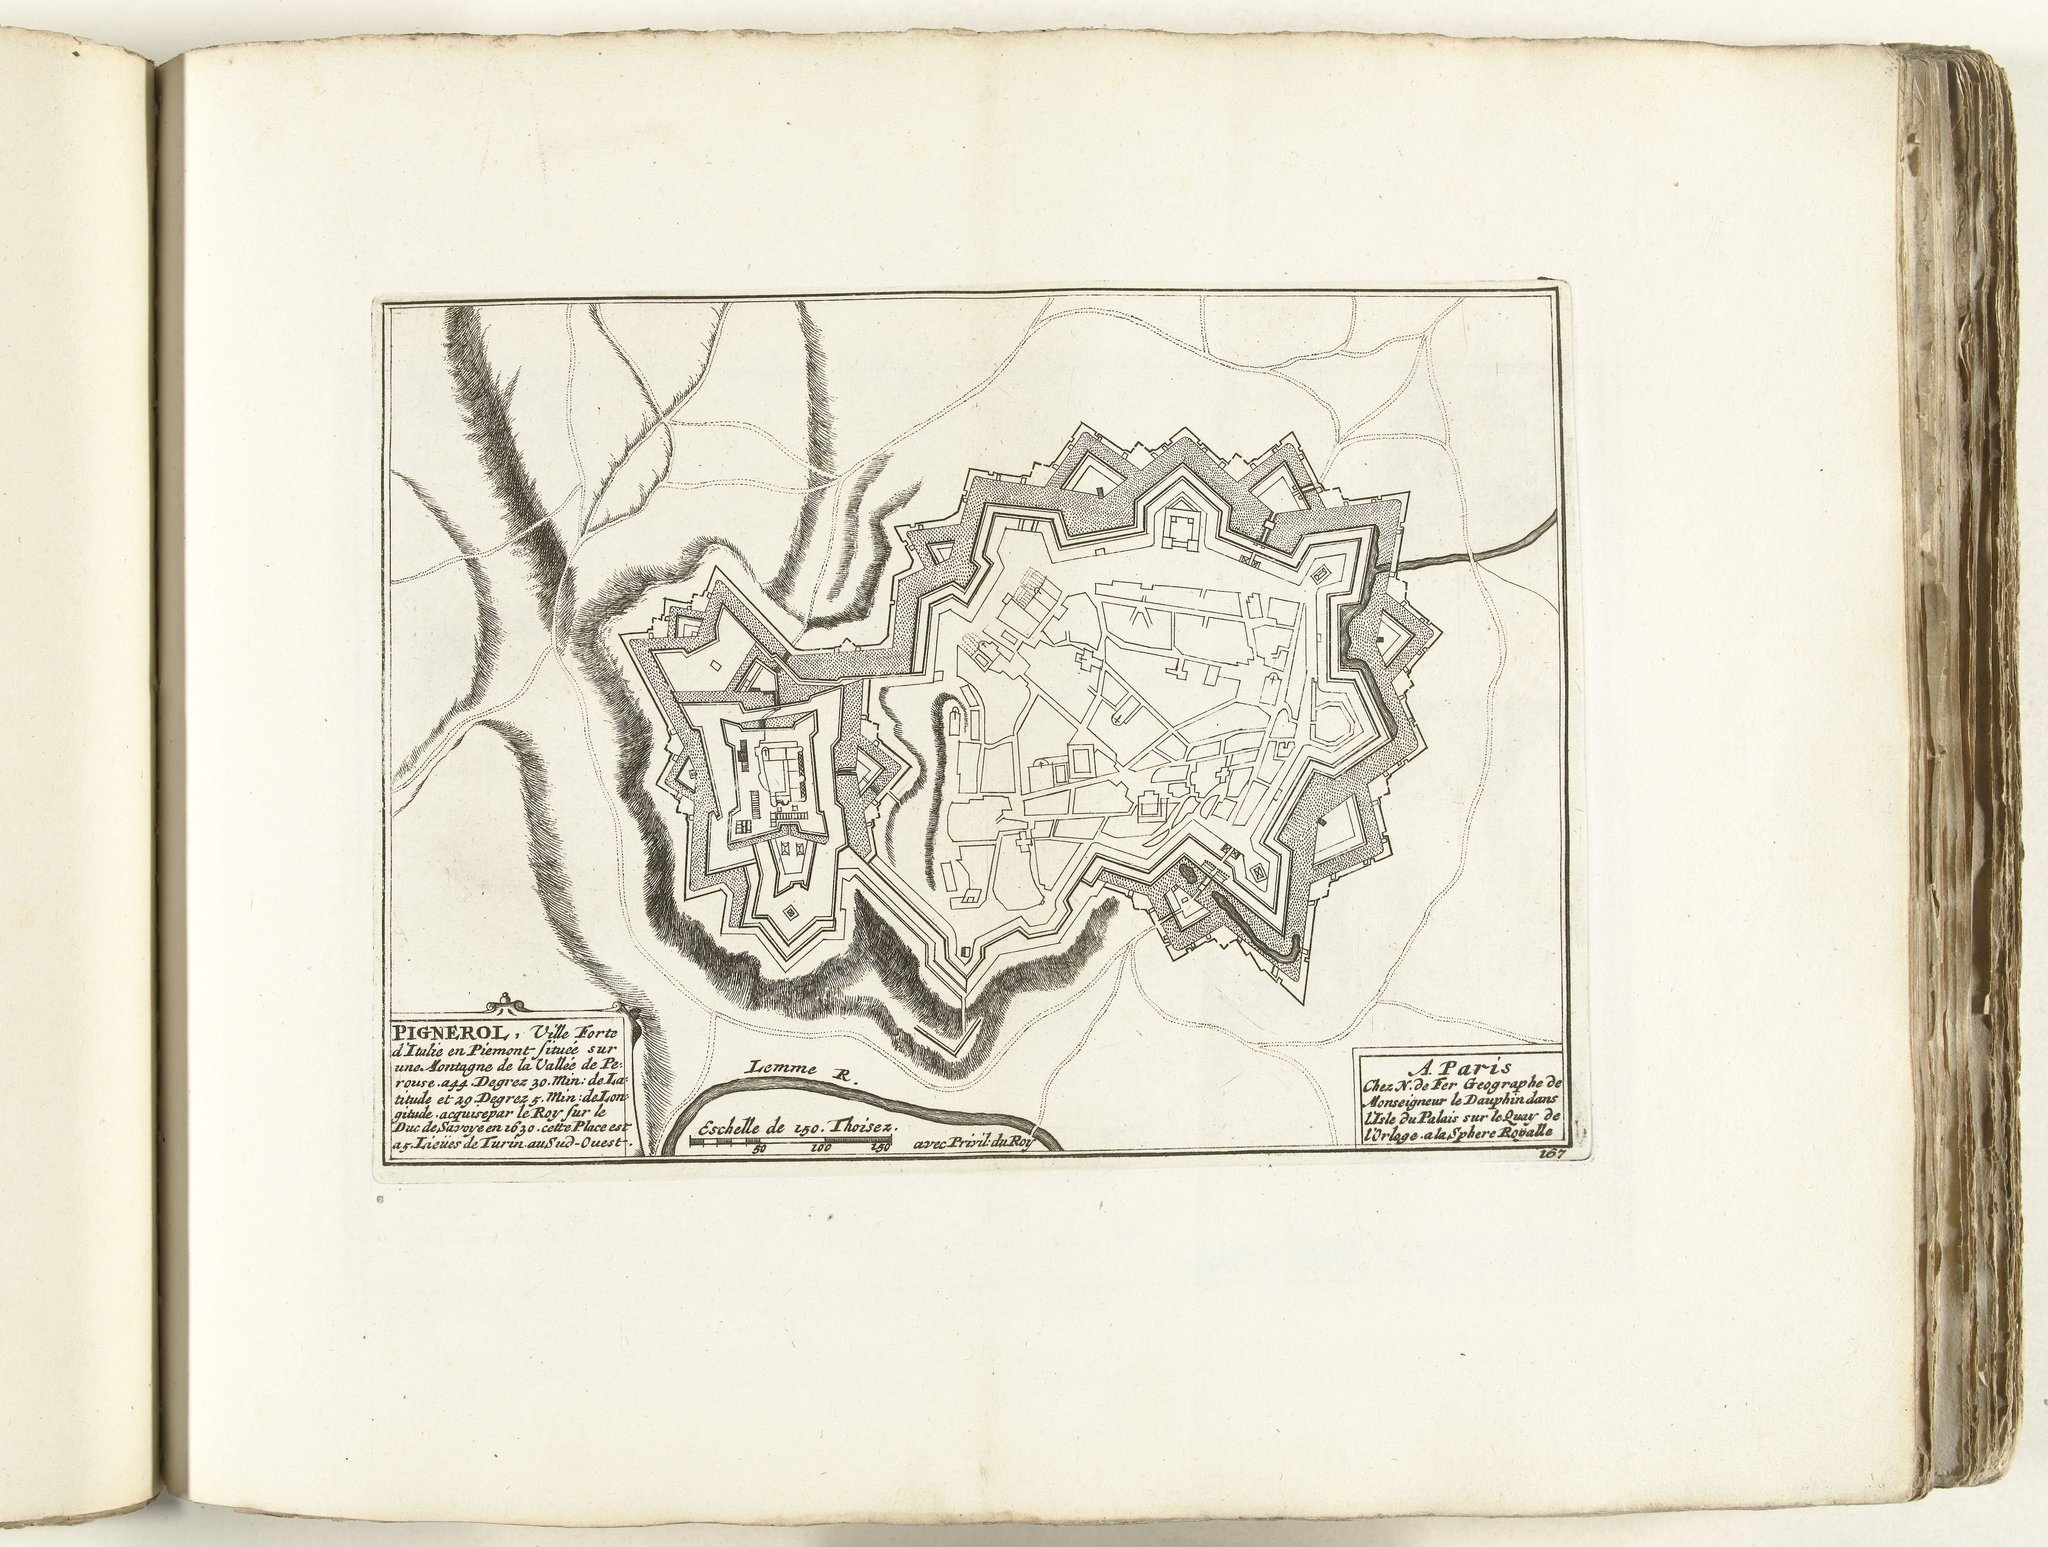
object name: print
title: Pignerol, Ville Forte d'Italie en Piemont (...)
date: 1702-1703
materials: paper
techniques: etching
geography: paris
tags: fortress, maps of cities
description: Plattegrond van de versterkingen om de Italiaanse stad Pinerolo (Pignerol). Plaat nr. 167 in het prentwerk bestaande in totaal uit 276 genummerde platen van vermaarde sterke steden en vestingen in het kader van de Spaanse Successieoorlog. Voor het merendeel zijn deze platen gekopieerd naar de anonieme Franse platen: in Les forces de l'Europe en in: Le theatre de la guerre, dans les Pays-Bas, beide oorspronkelijk uitgegeven door Nicolas de Fer te Parijs (1693-1697) in het kader van de Negenjarige Oorlog. Titel en opschriften in de plaat in het Frans.